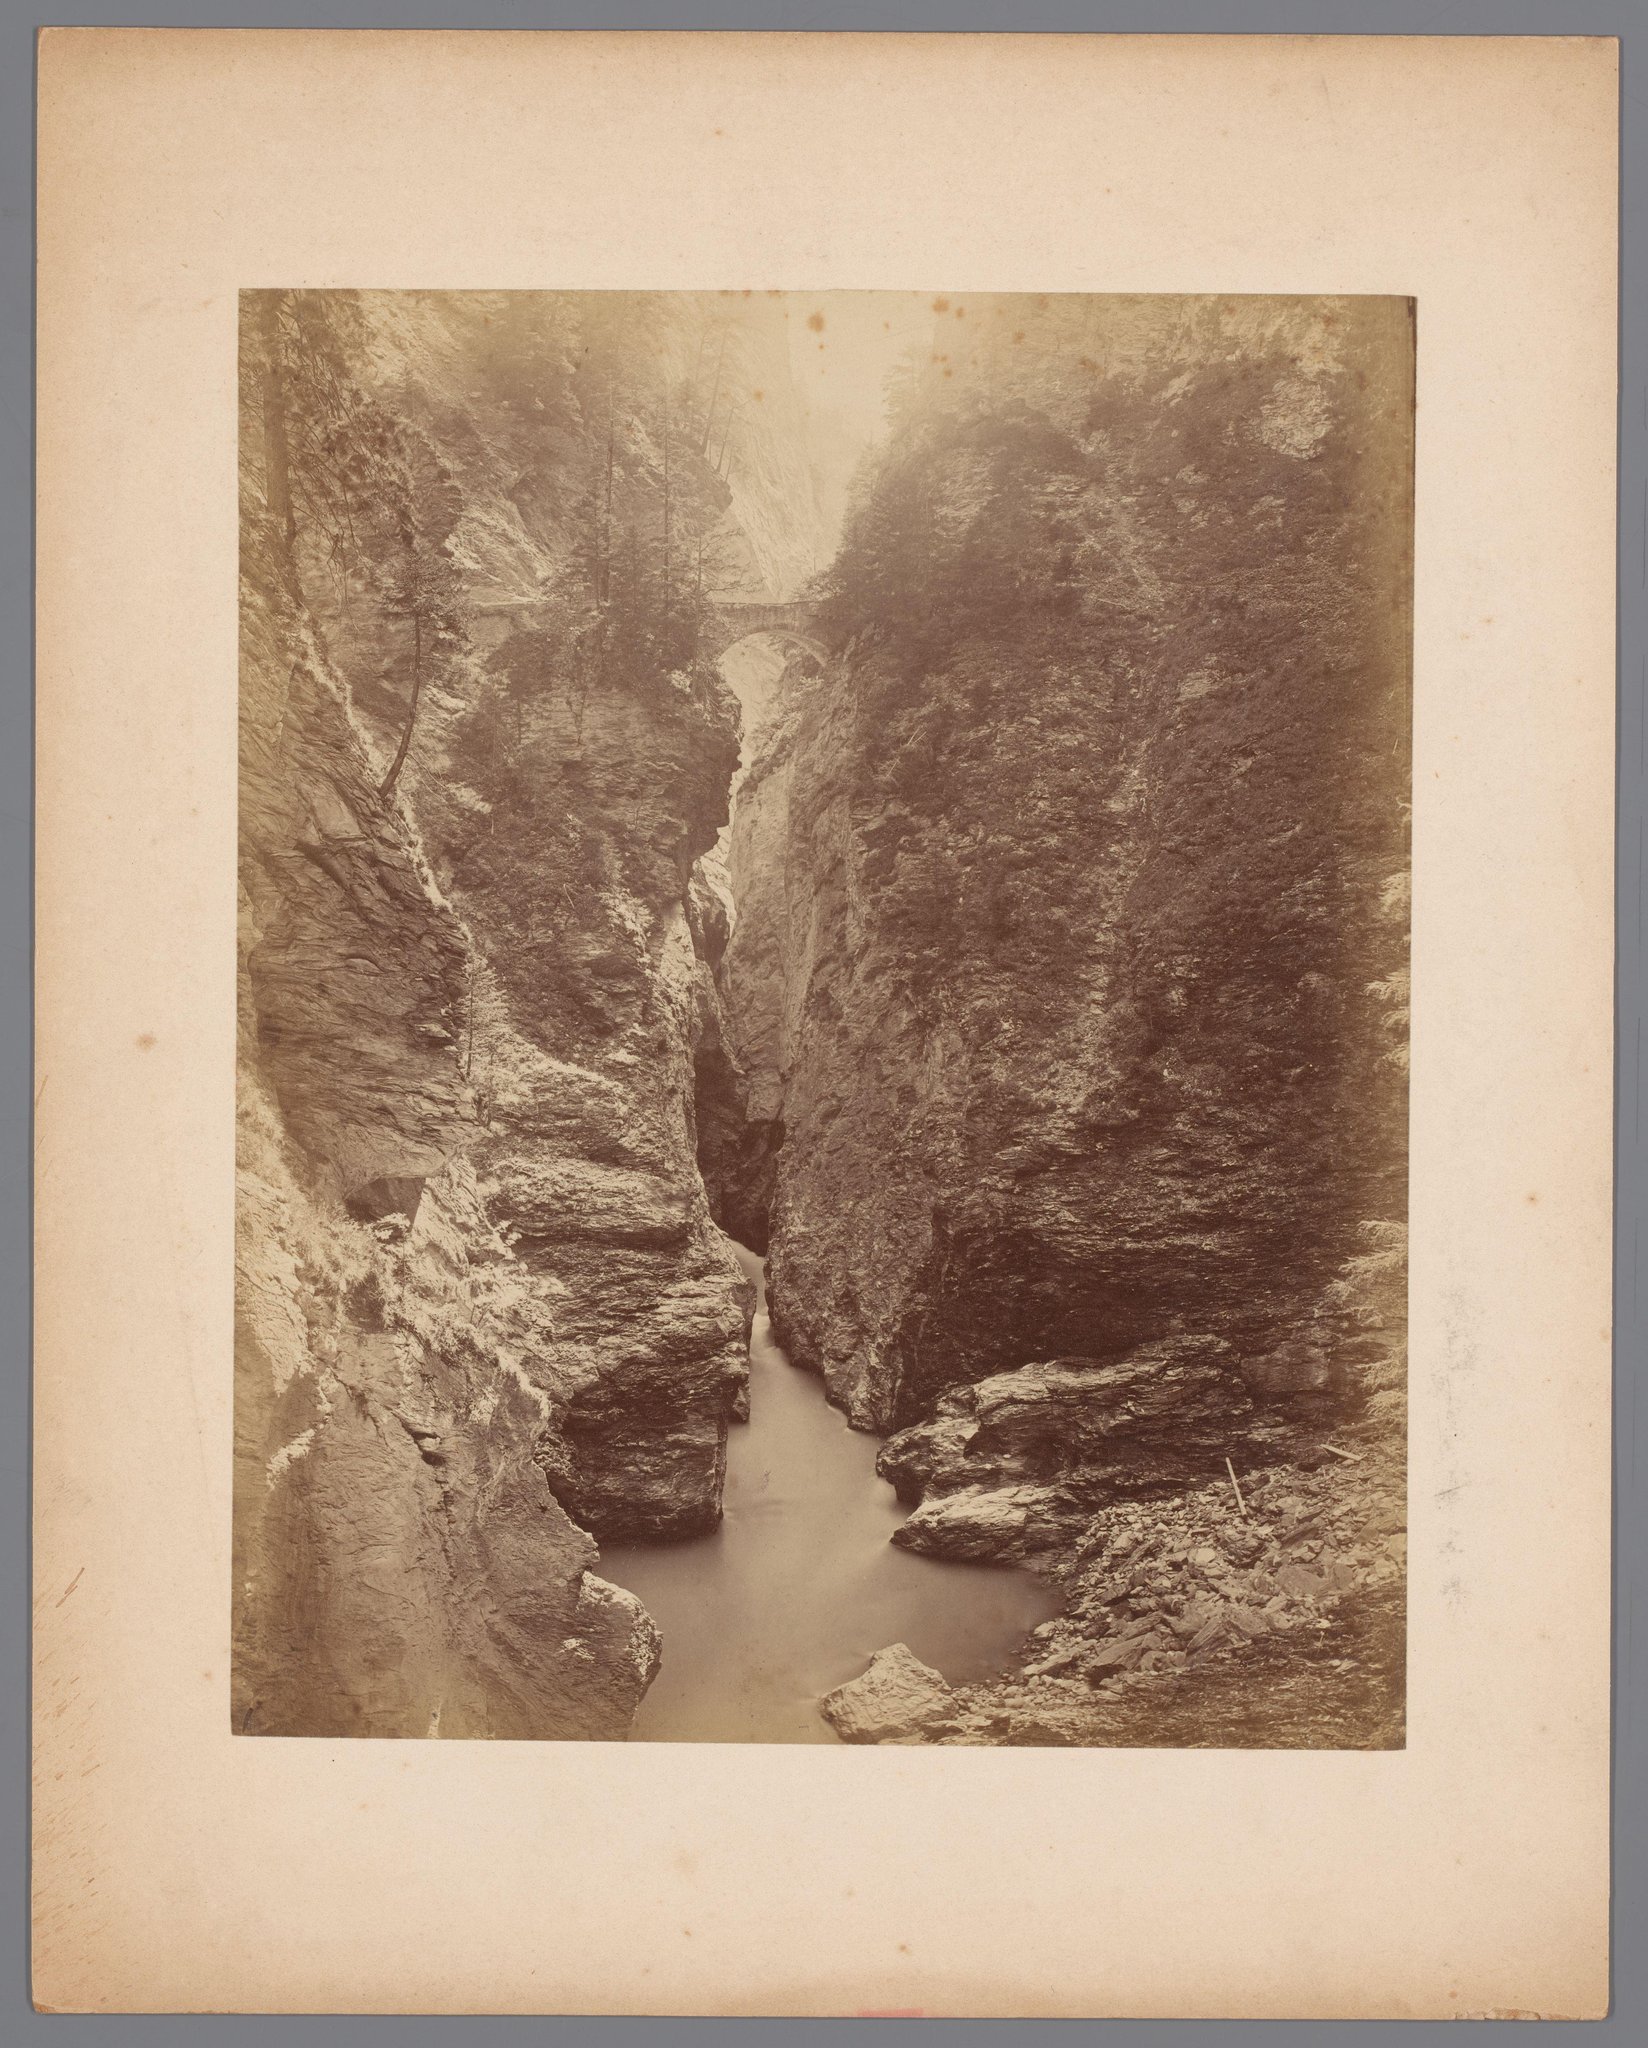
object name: photograph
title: Via Mala, nabij Tuses (kanton Graubünden/Grisons), Zwitserland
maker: Anonymous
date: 1885-1900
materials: cardboard, paper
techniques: albumen print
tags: switzerland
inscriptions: inscription: ‘Via Mala’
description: Via Mala, nabij Tuses (kanton Graubünden/Grisons), Zwitserland.